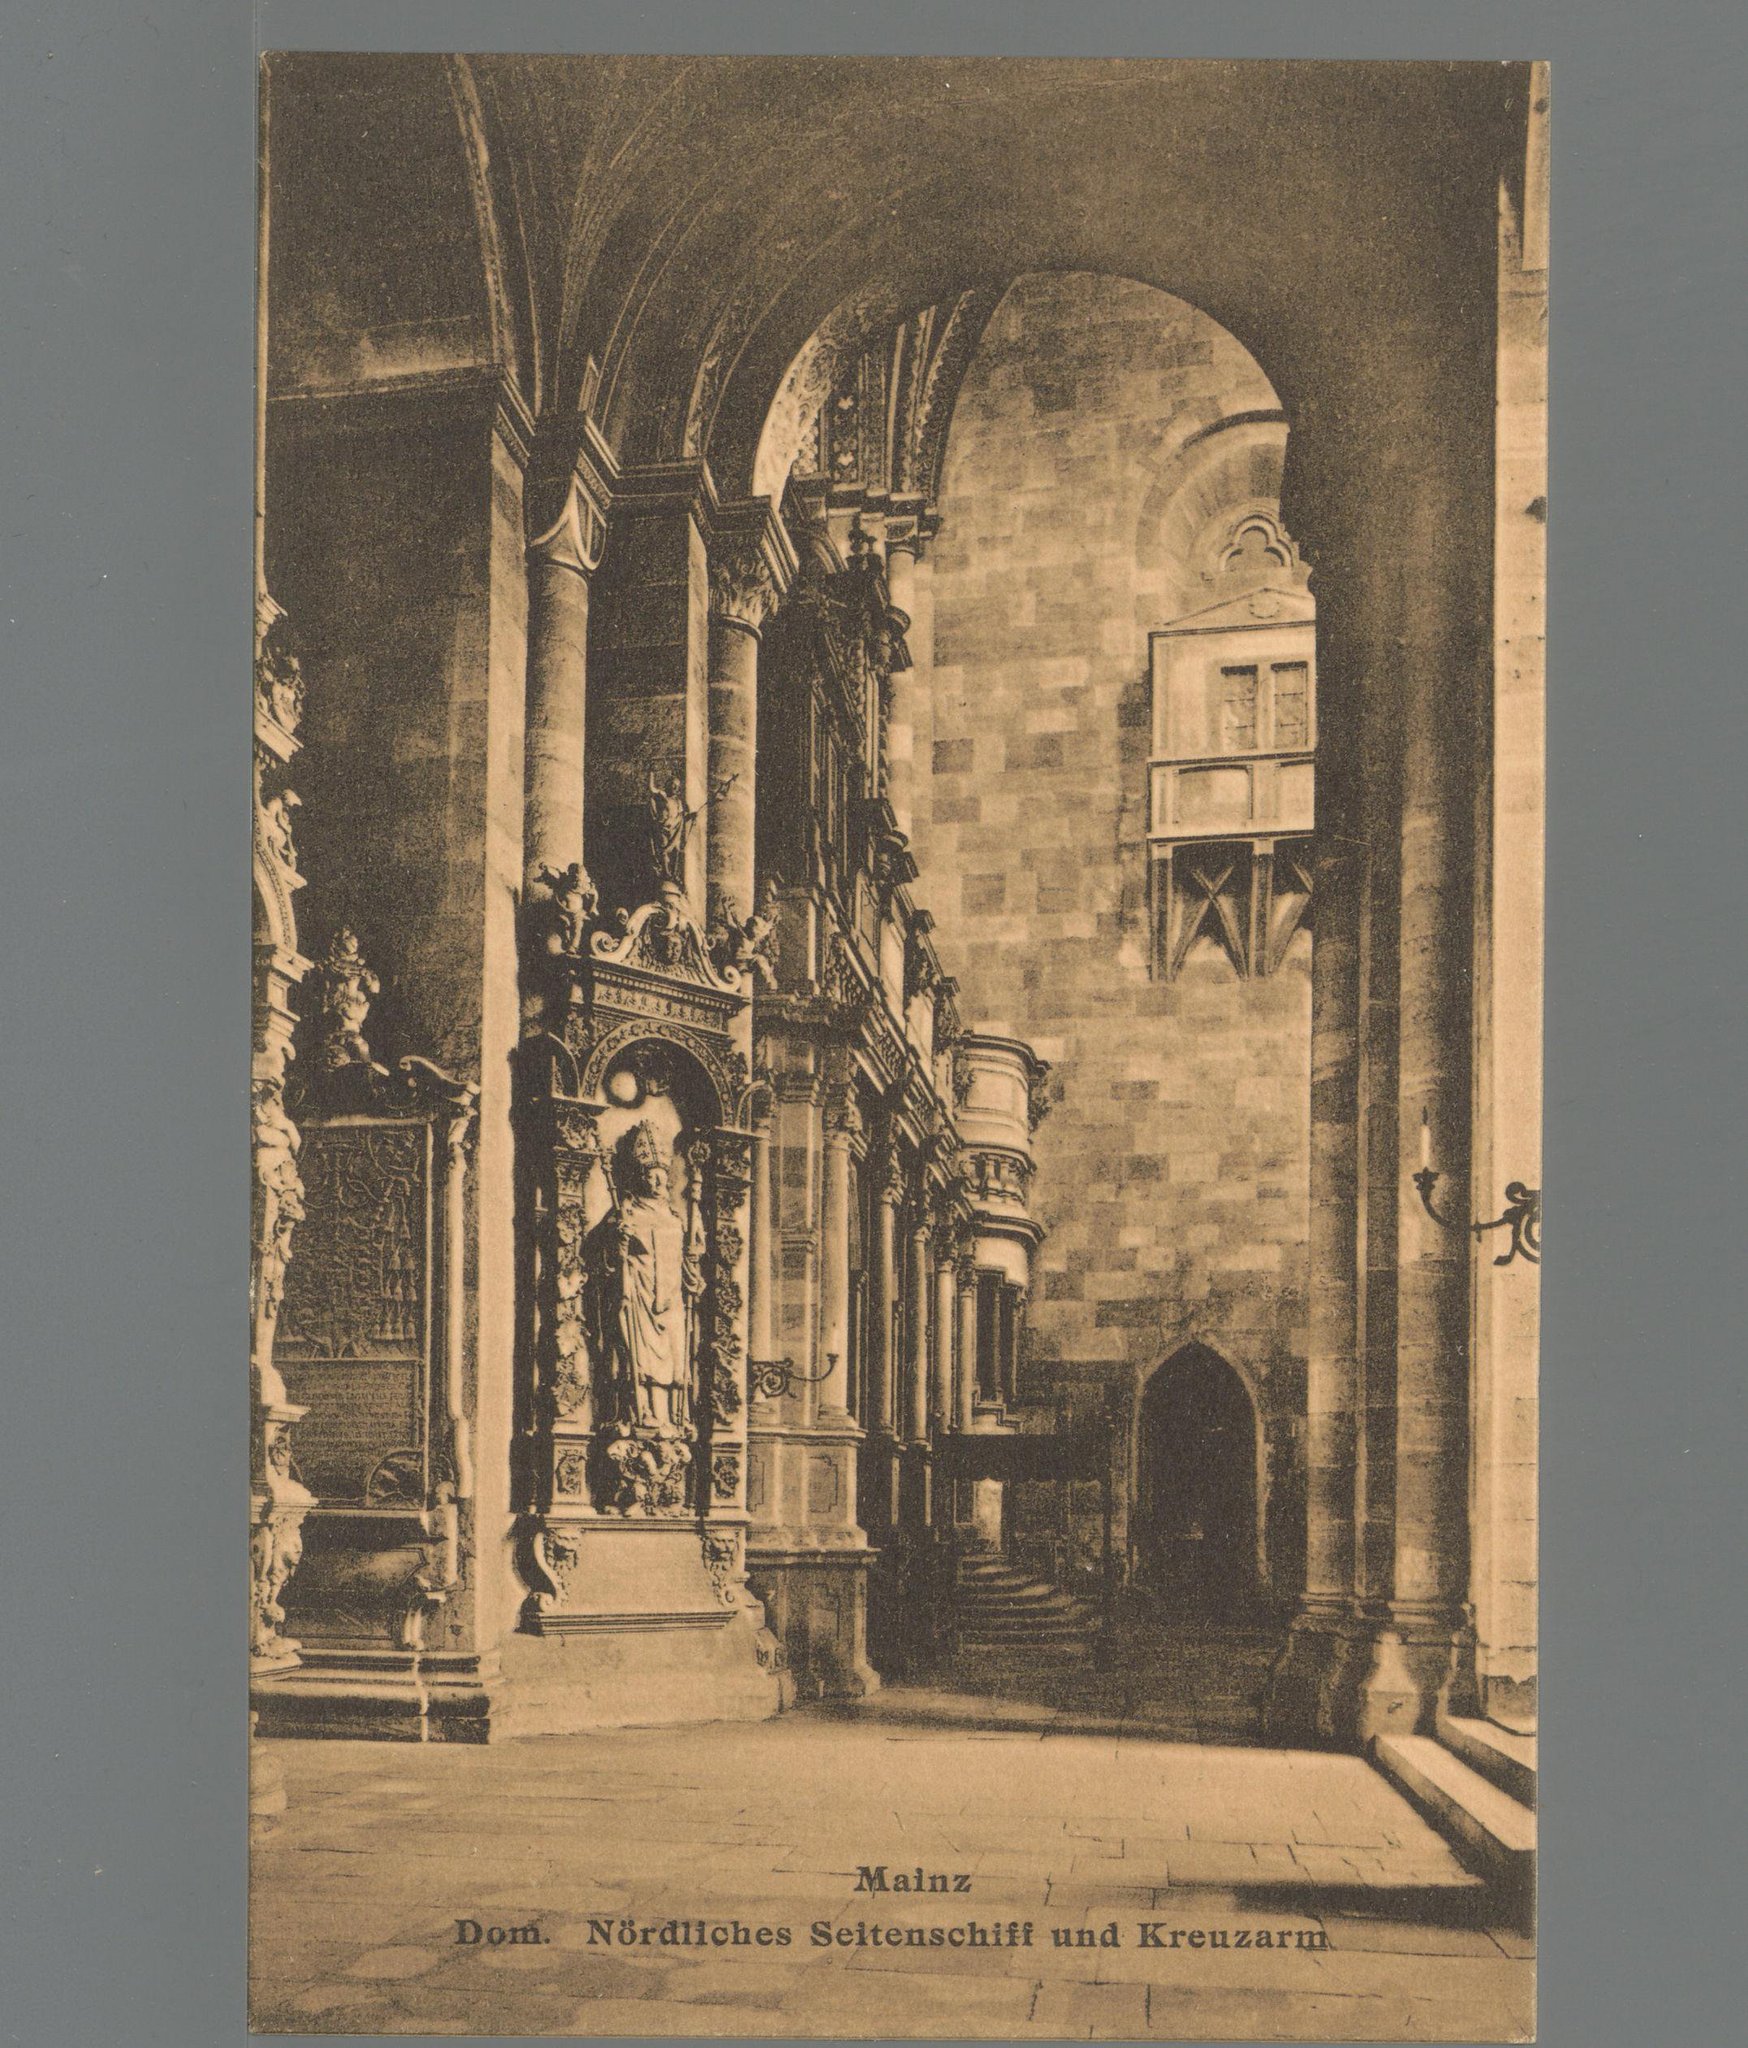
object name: photomechanical print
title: Mainz. Dom. Nördliches Seitenschiff und Kreuzarm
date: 1906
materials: cardboard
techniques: photograph, writing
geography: mainz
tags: parts of church interior: nave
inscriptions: date